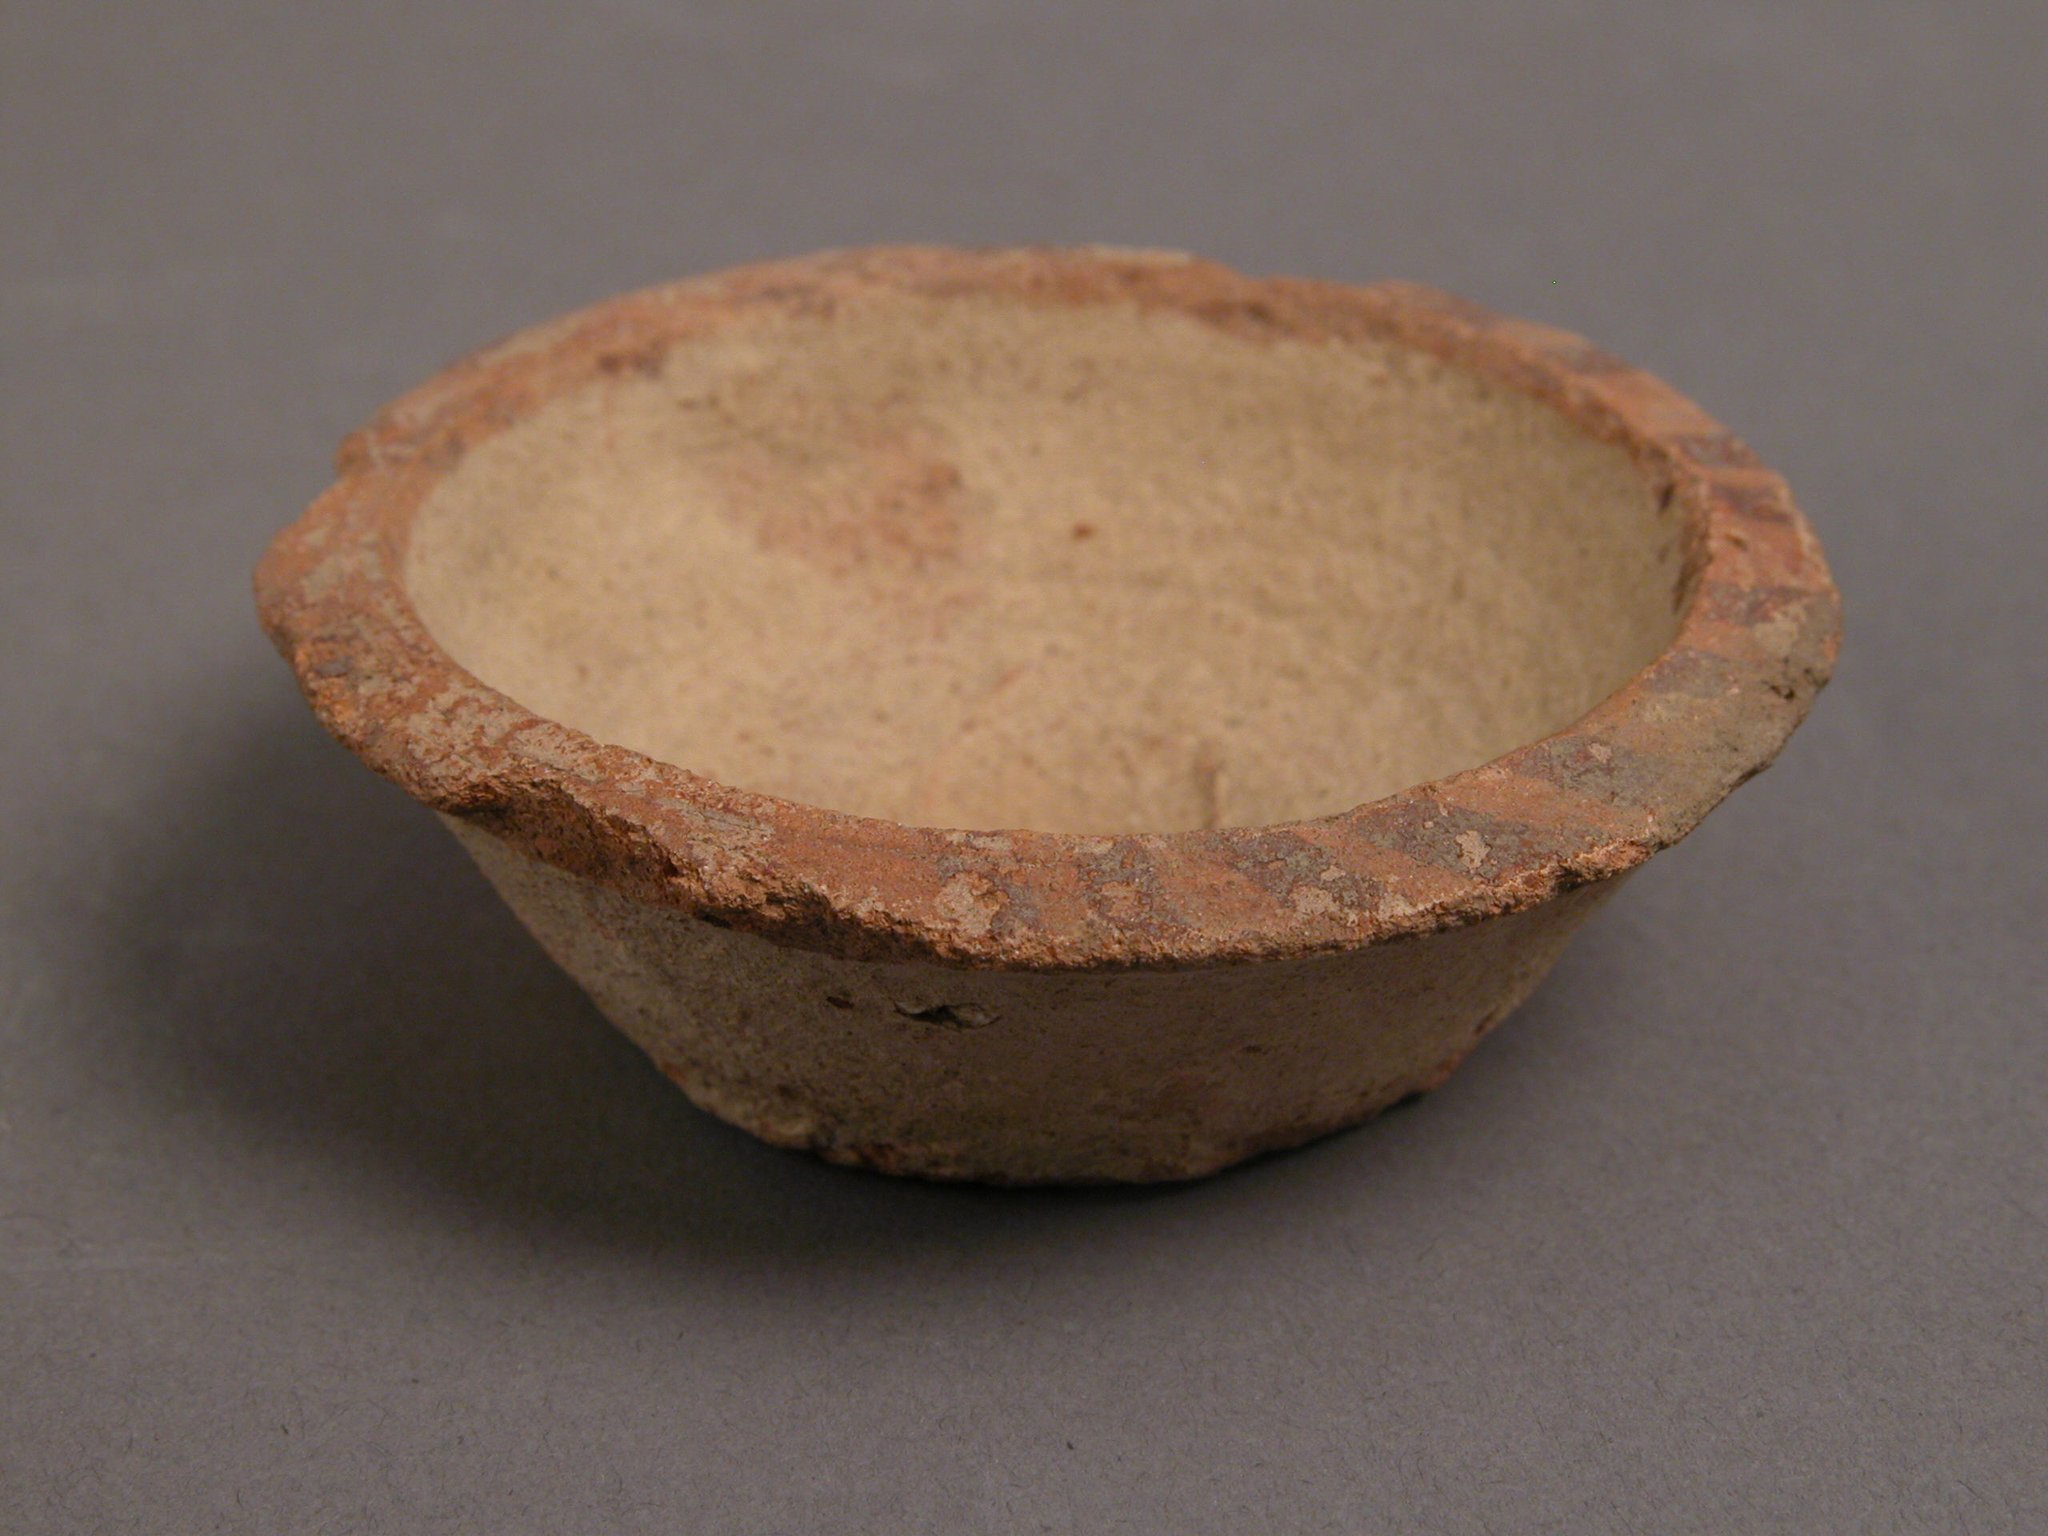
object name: bowl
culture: coptic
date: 301-700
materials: earthenware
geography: egypt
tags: bowls